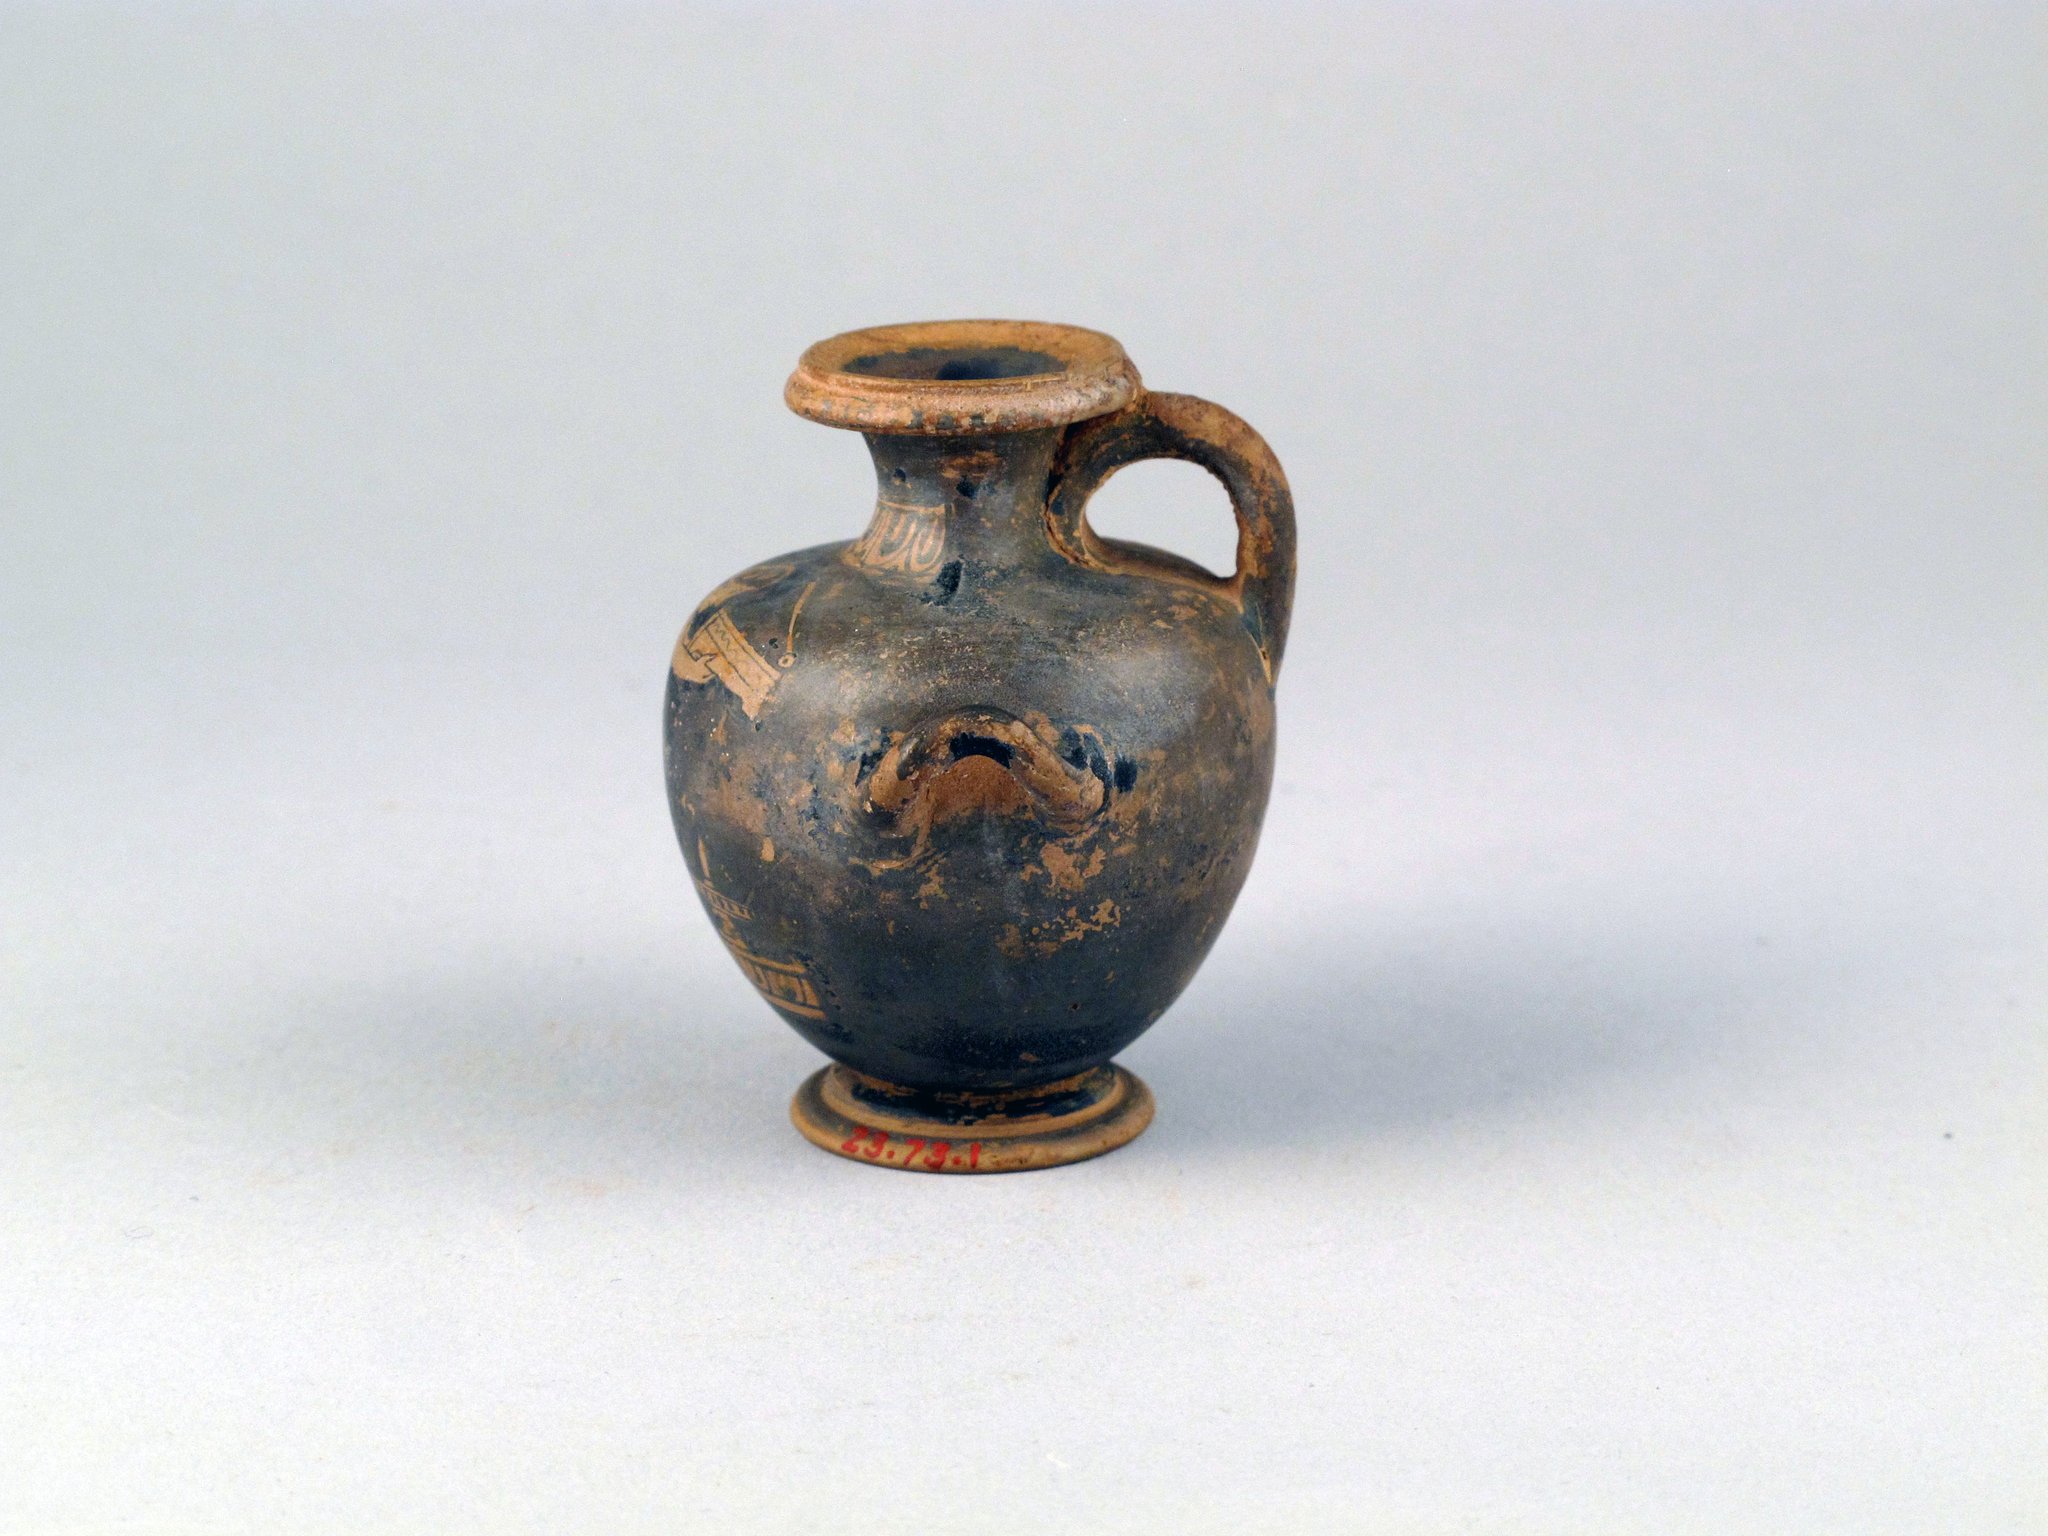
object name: hydria, miniature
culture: greek, attic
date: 500-401 BCE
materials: terracotta